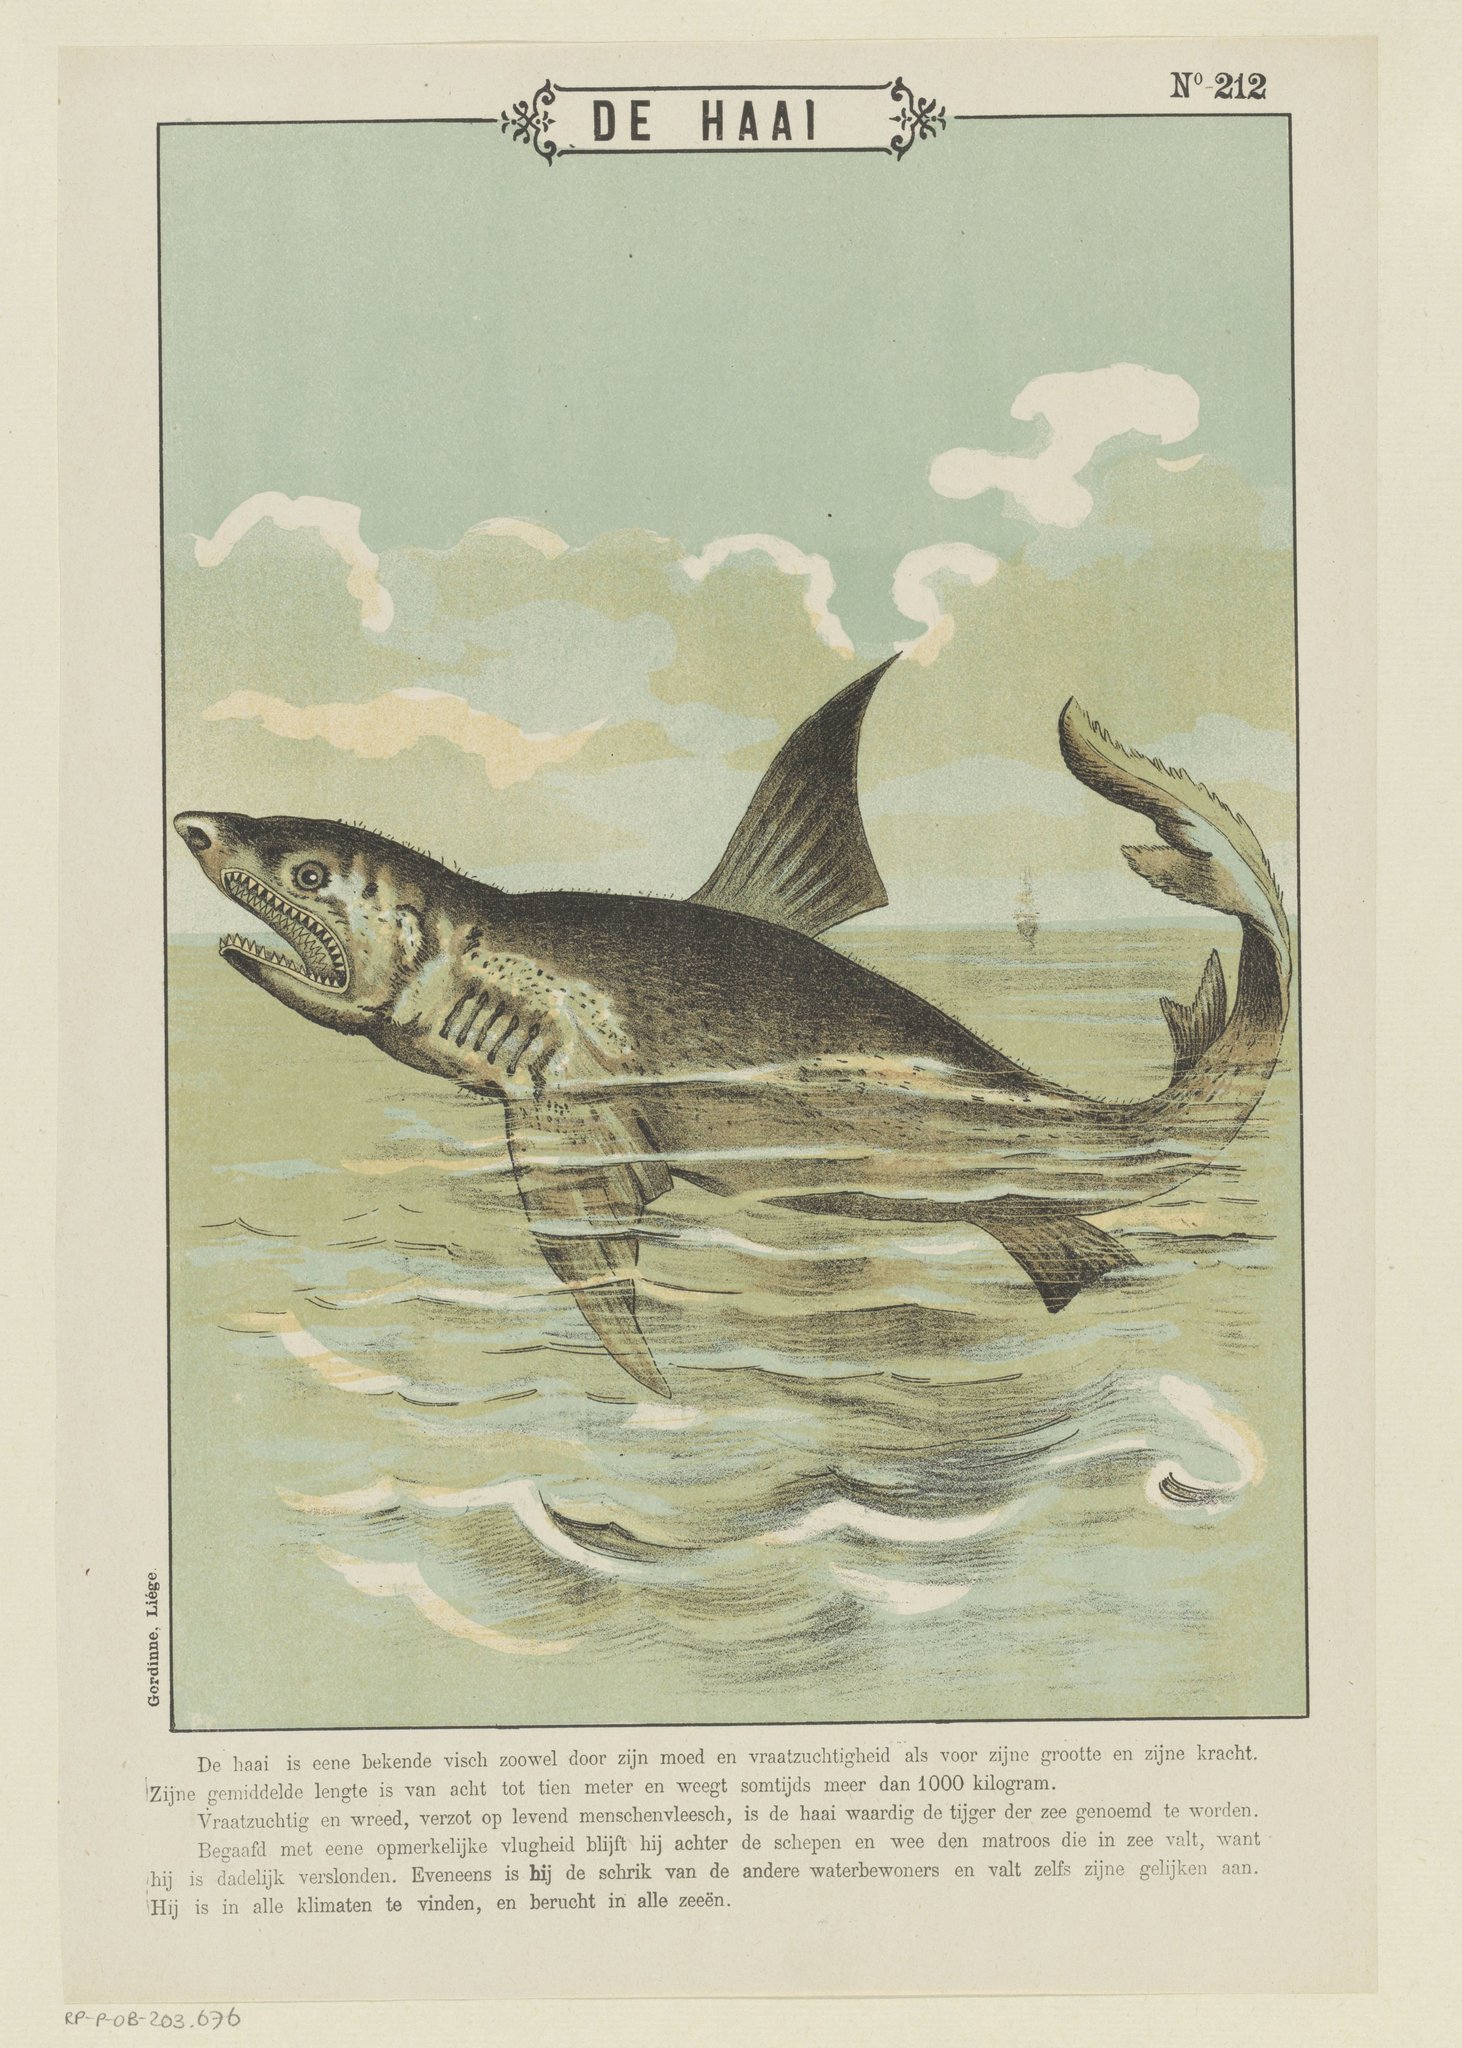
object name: print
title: De haai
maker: Anonymous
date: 1894-1959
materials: paper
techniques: lithograph, letterpress printing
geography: liège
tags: cartilaginous fishes: shark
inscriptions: collector's mark: Lugt 2760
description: Blad met een grote voorstelling van een haai. In de ondermarge een onderschrift. Genummerd rechtsboven: No 212.